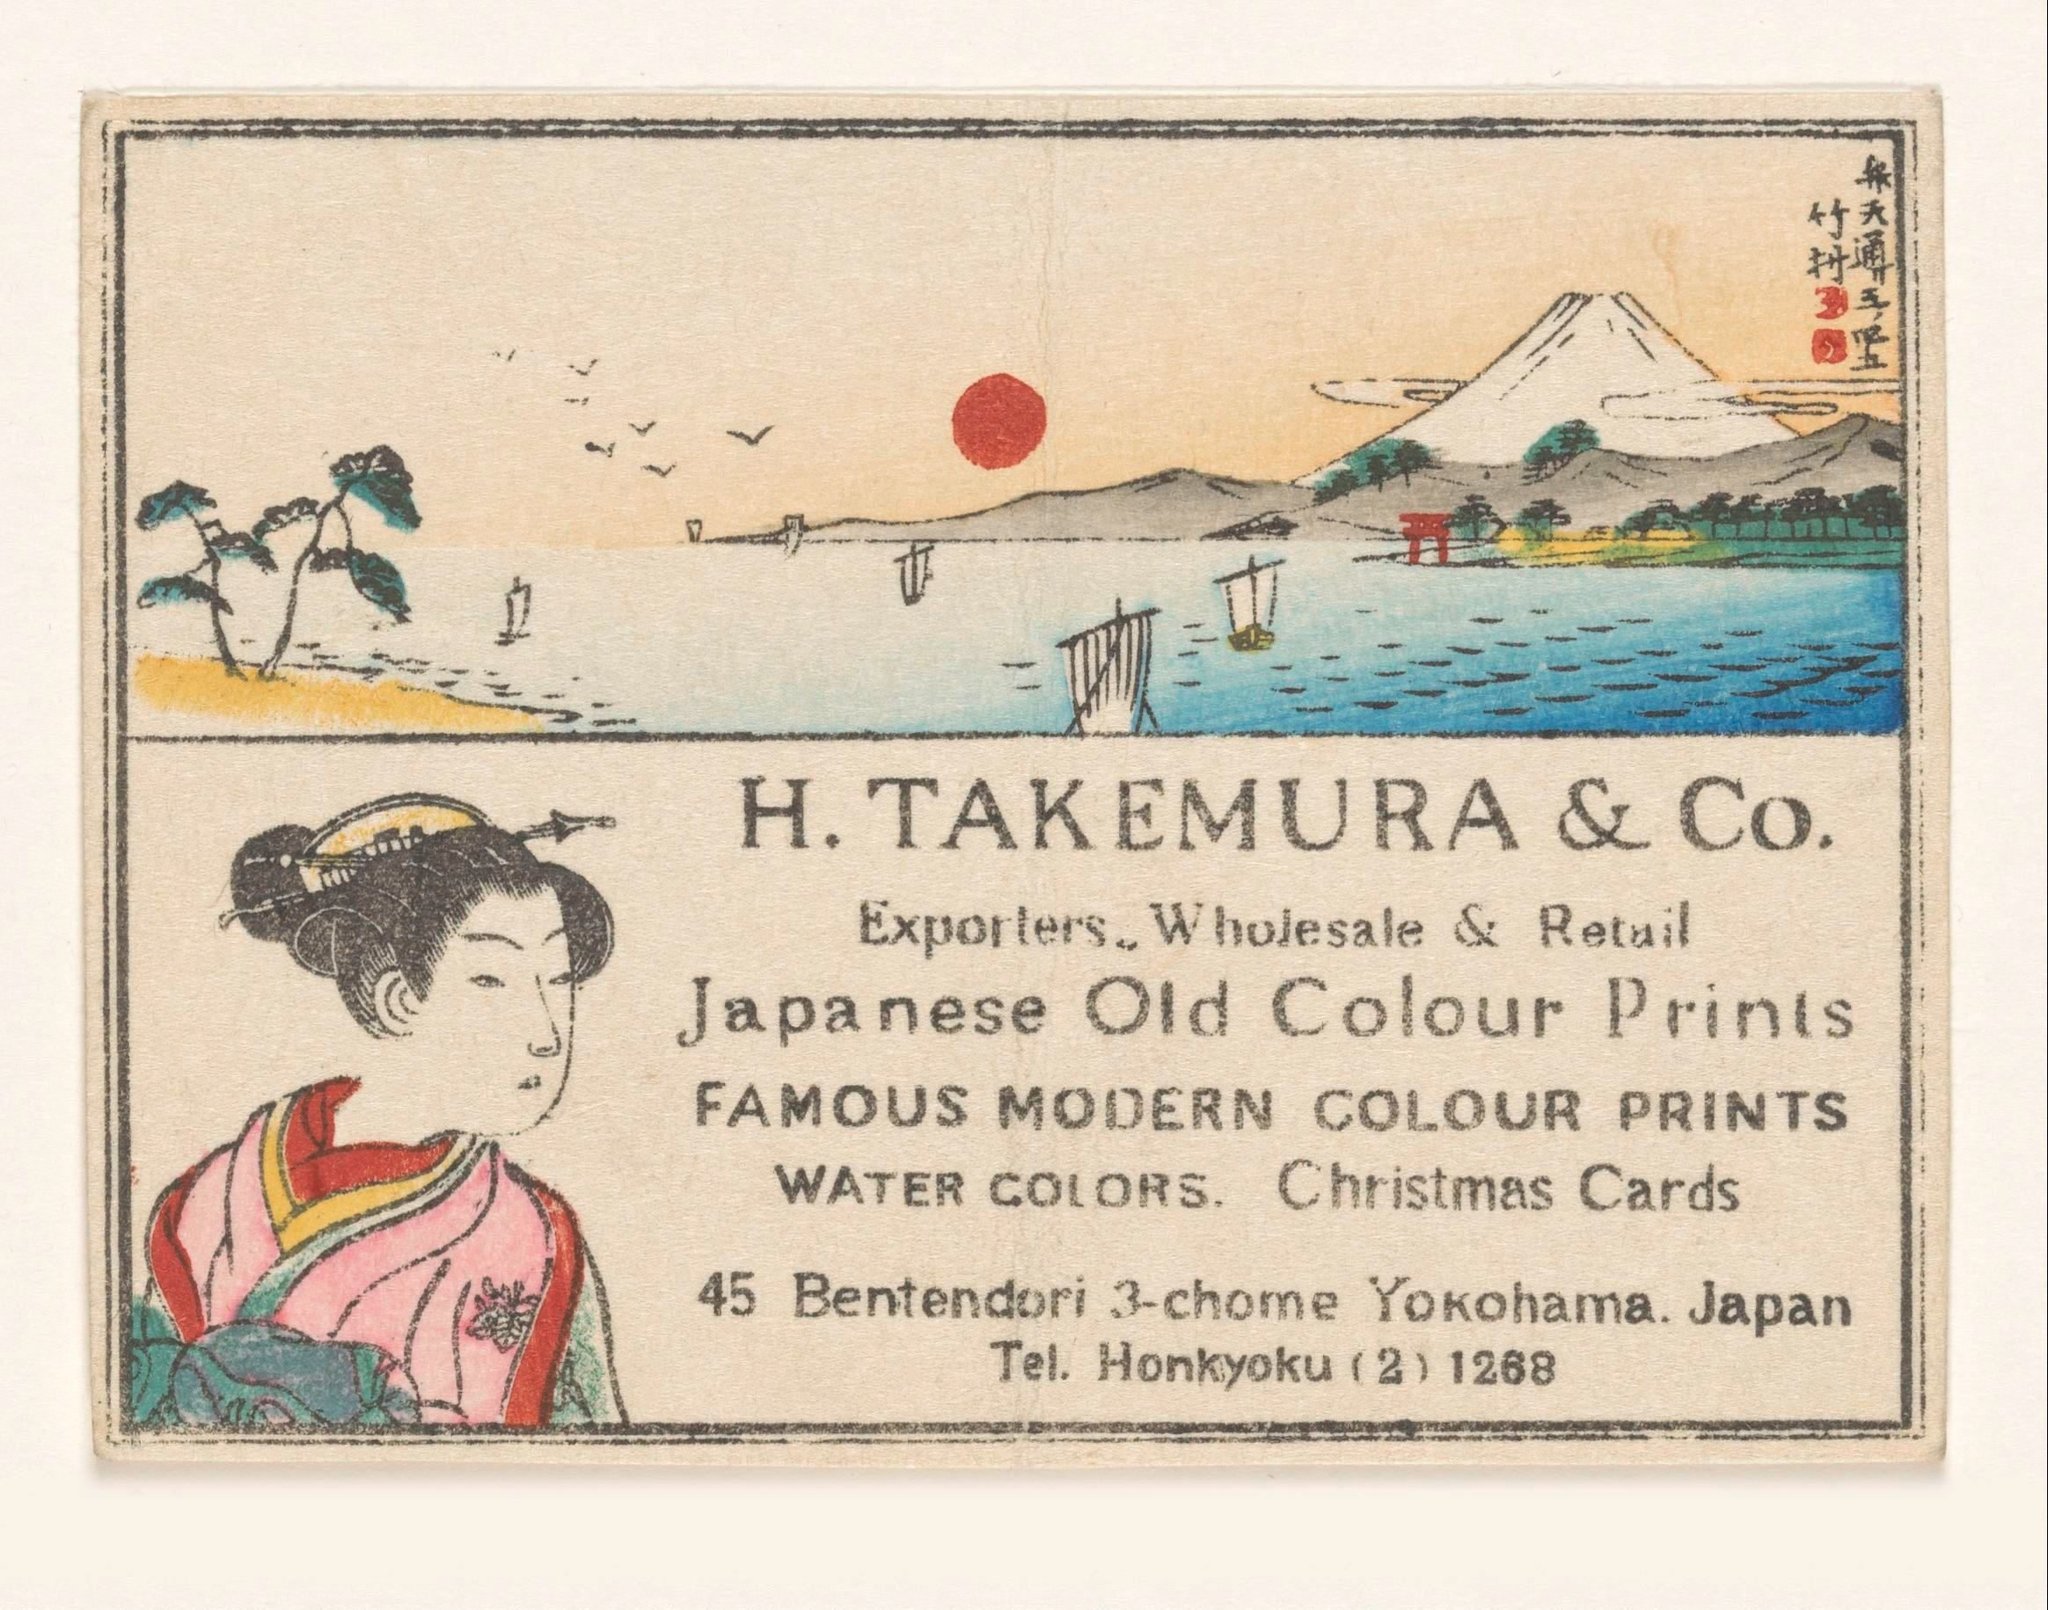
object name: visiting card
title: Visitekaartje van uitgever Takemura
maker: Anonymous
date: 1920-1950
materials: paper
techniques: woodcut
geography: japan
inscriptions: collector's mark: Lugt 4780, collector's mark: Lugt 2228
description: Japanse vrouw, ten halven lijve, kijkend naar naam en adres (in Engels) van de uitgever Hideo Takemura, waarboven kustlandschap met uitzicht op de berg Fuji.